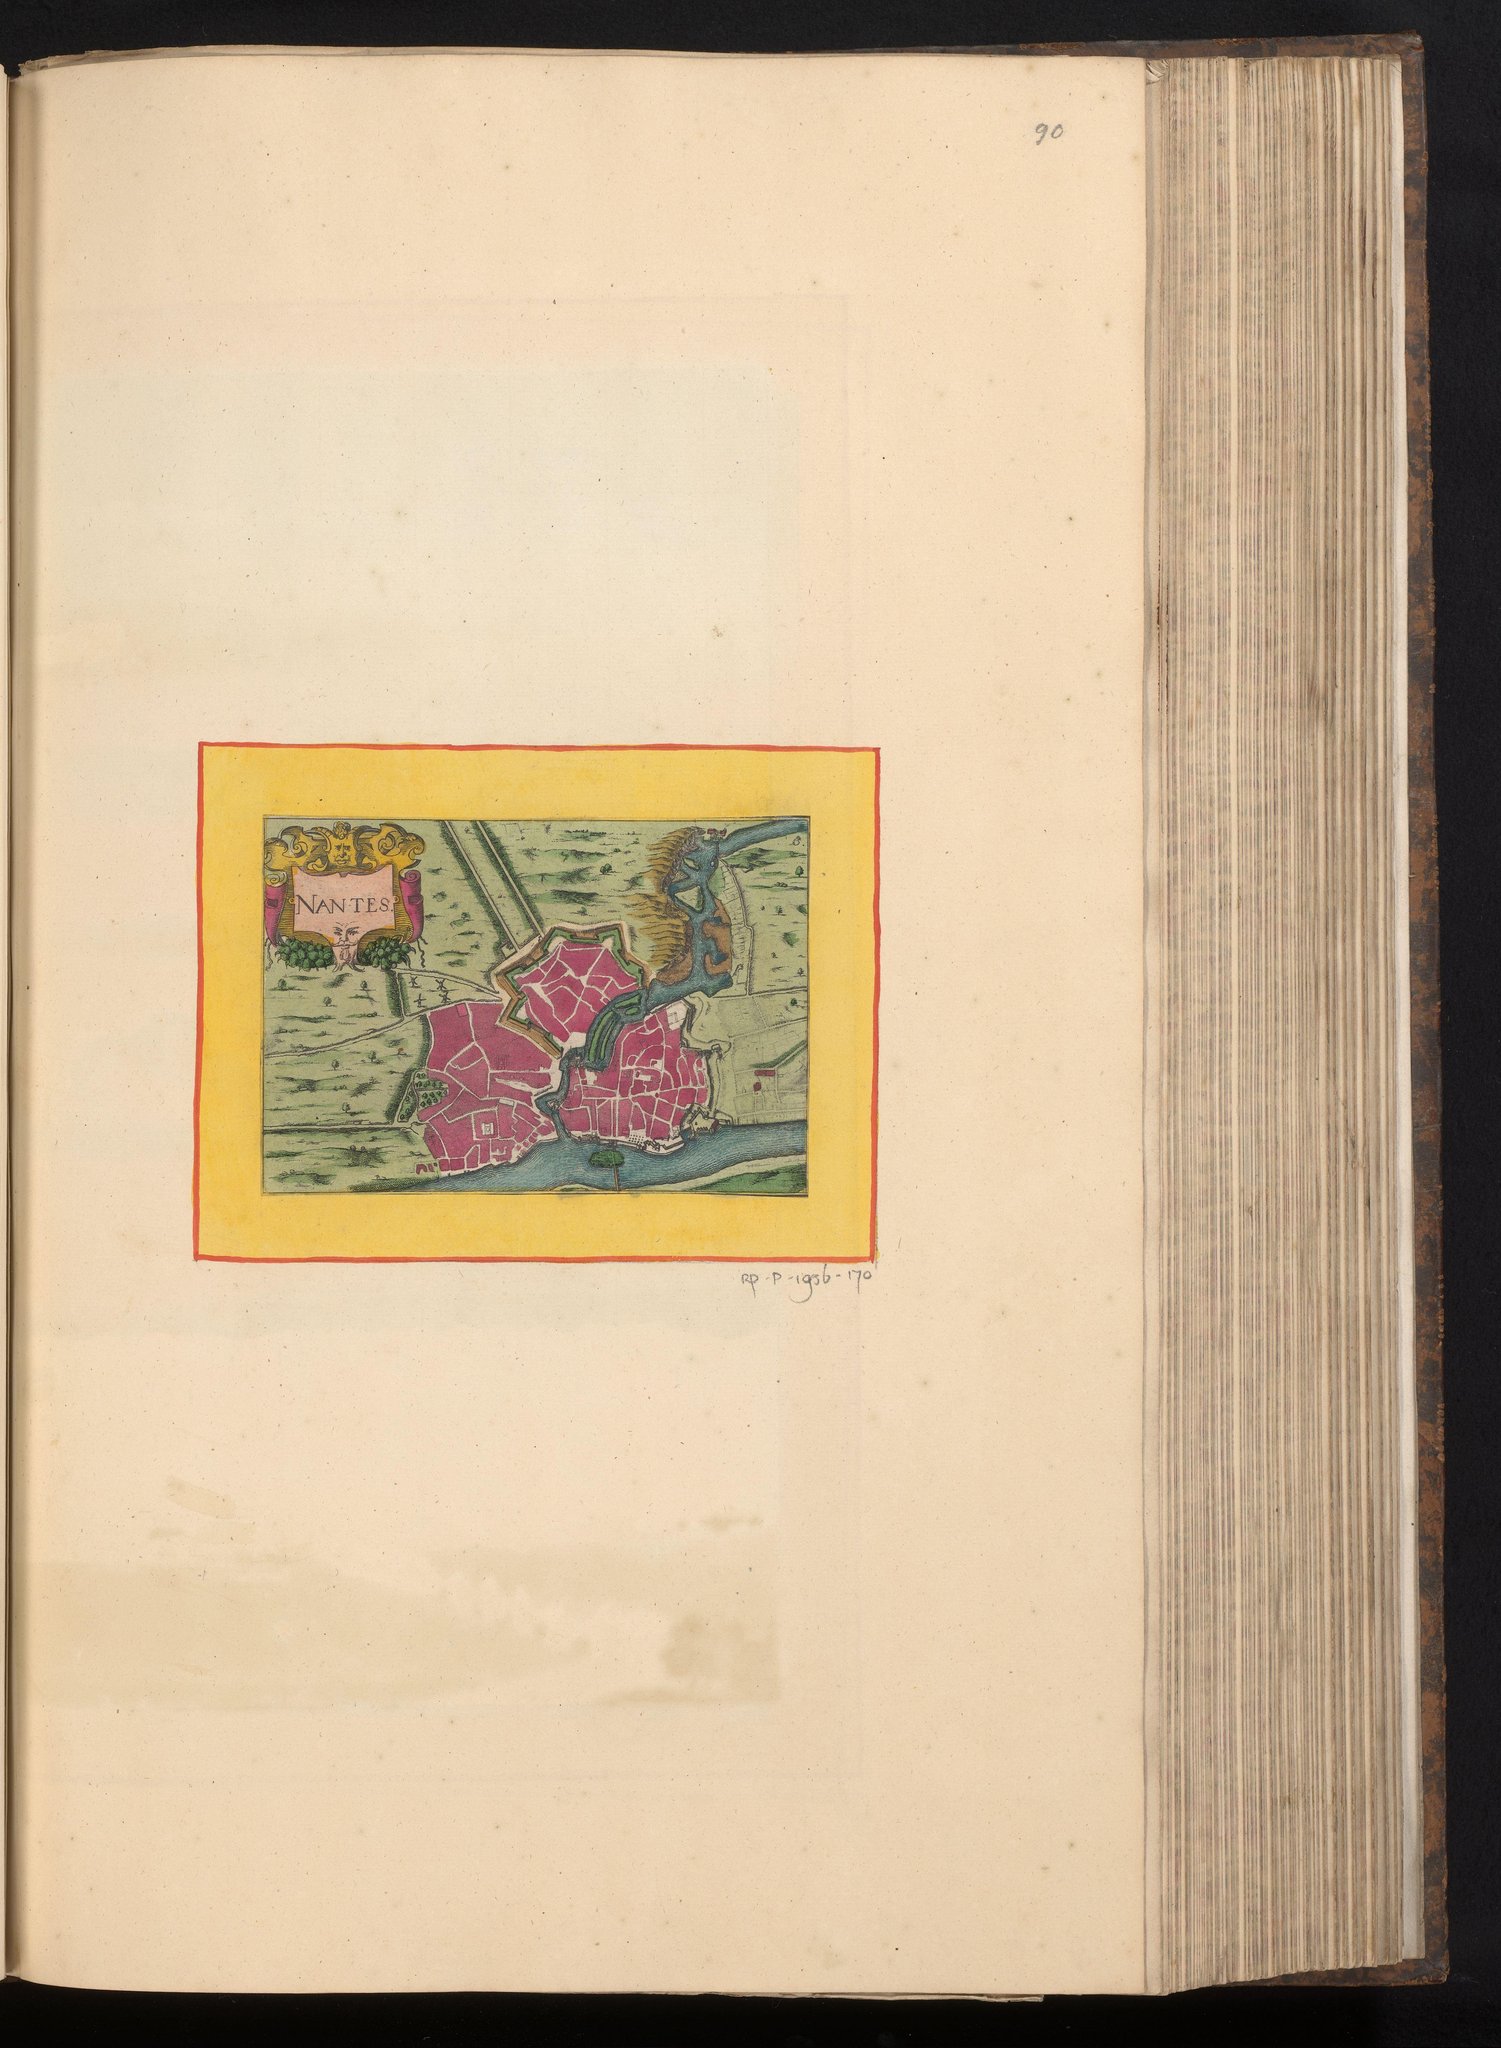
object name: album leaf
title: Nantes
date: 1638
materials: paper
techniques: engraving, etching, hand coloring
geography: paris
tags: maps of cities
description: Prent uit: Tassin, Christophe. Les plans et profils de toutes les principales villes et lieux considérables de France (...). Parijs: Michel van Lochom, 1638, prent nummer 8 in het deel 'Bretaigne'.